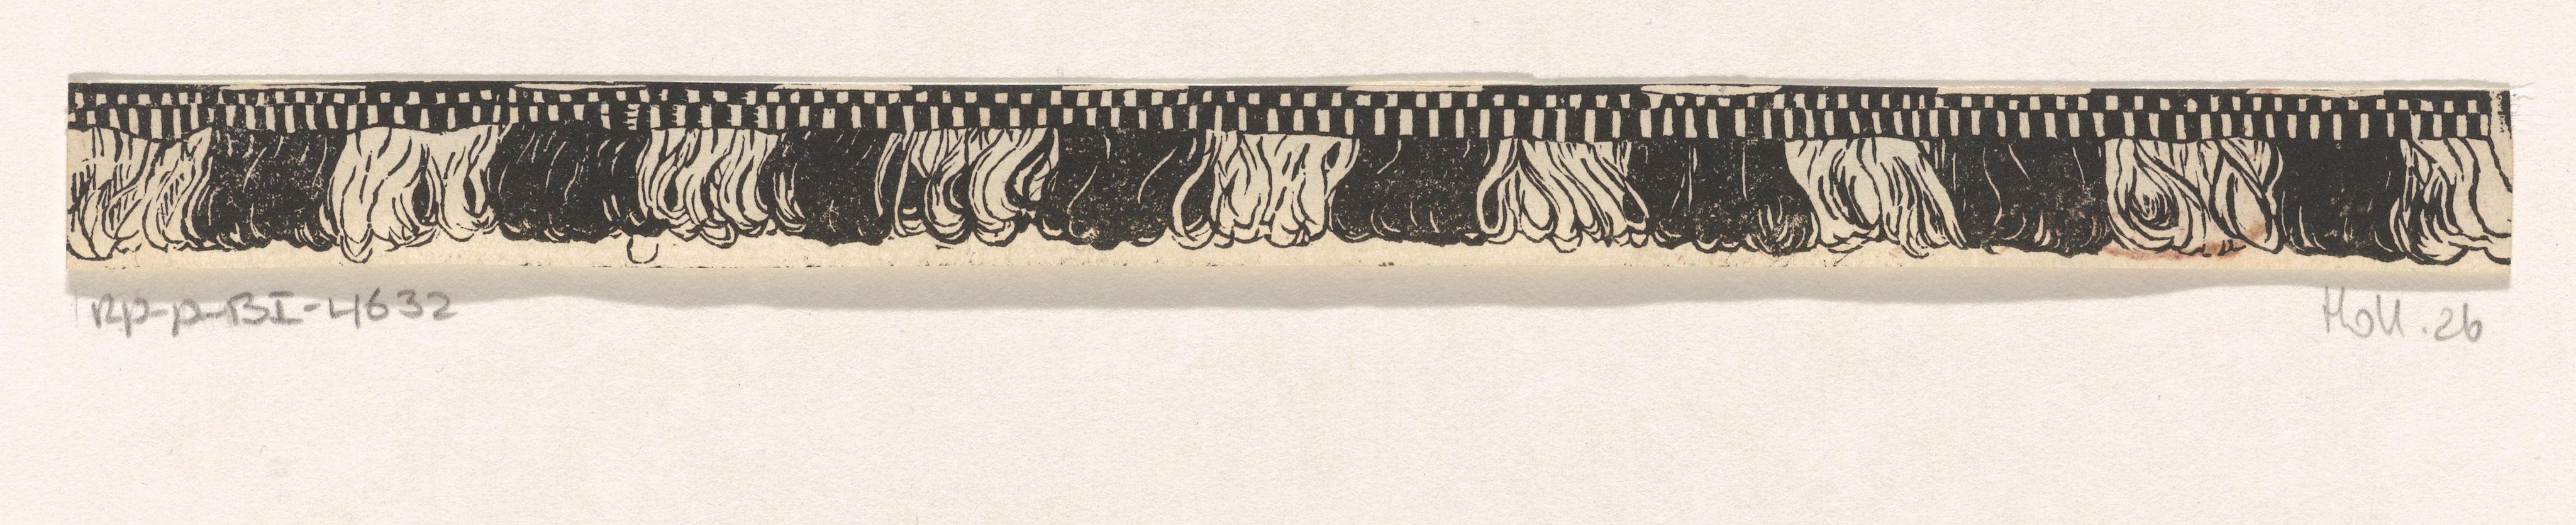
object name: print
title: Lint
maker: isaac vincentsz. van der vinne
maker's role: draughtsman, print maker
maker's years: 1665-1740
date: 1681-1740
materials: paper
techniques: woodcut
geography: haarlem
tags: ribbon, scroll, banderole ~ ornament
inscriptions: collector's mark: Lugt 240